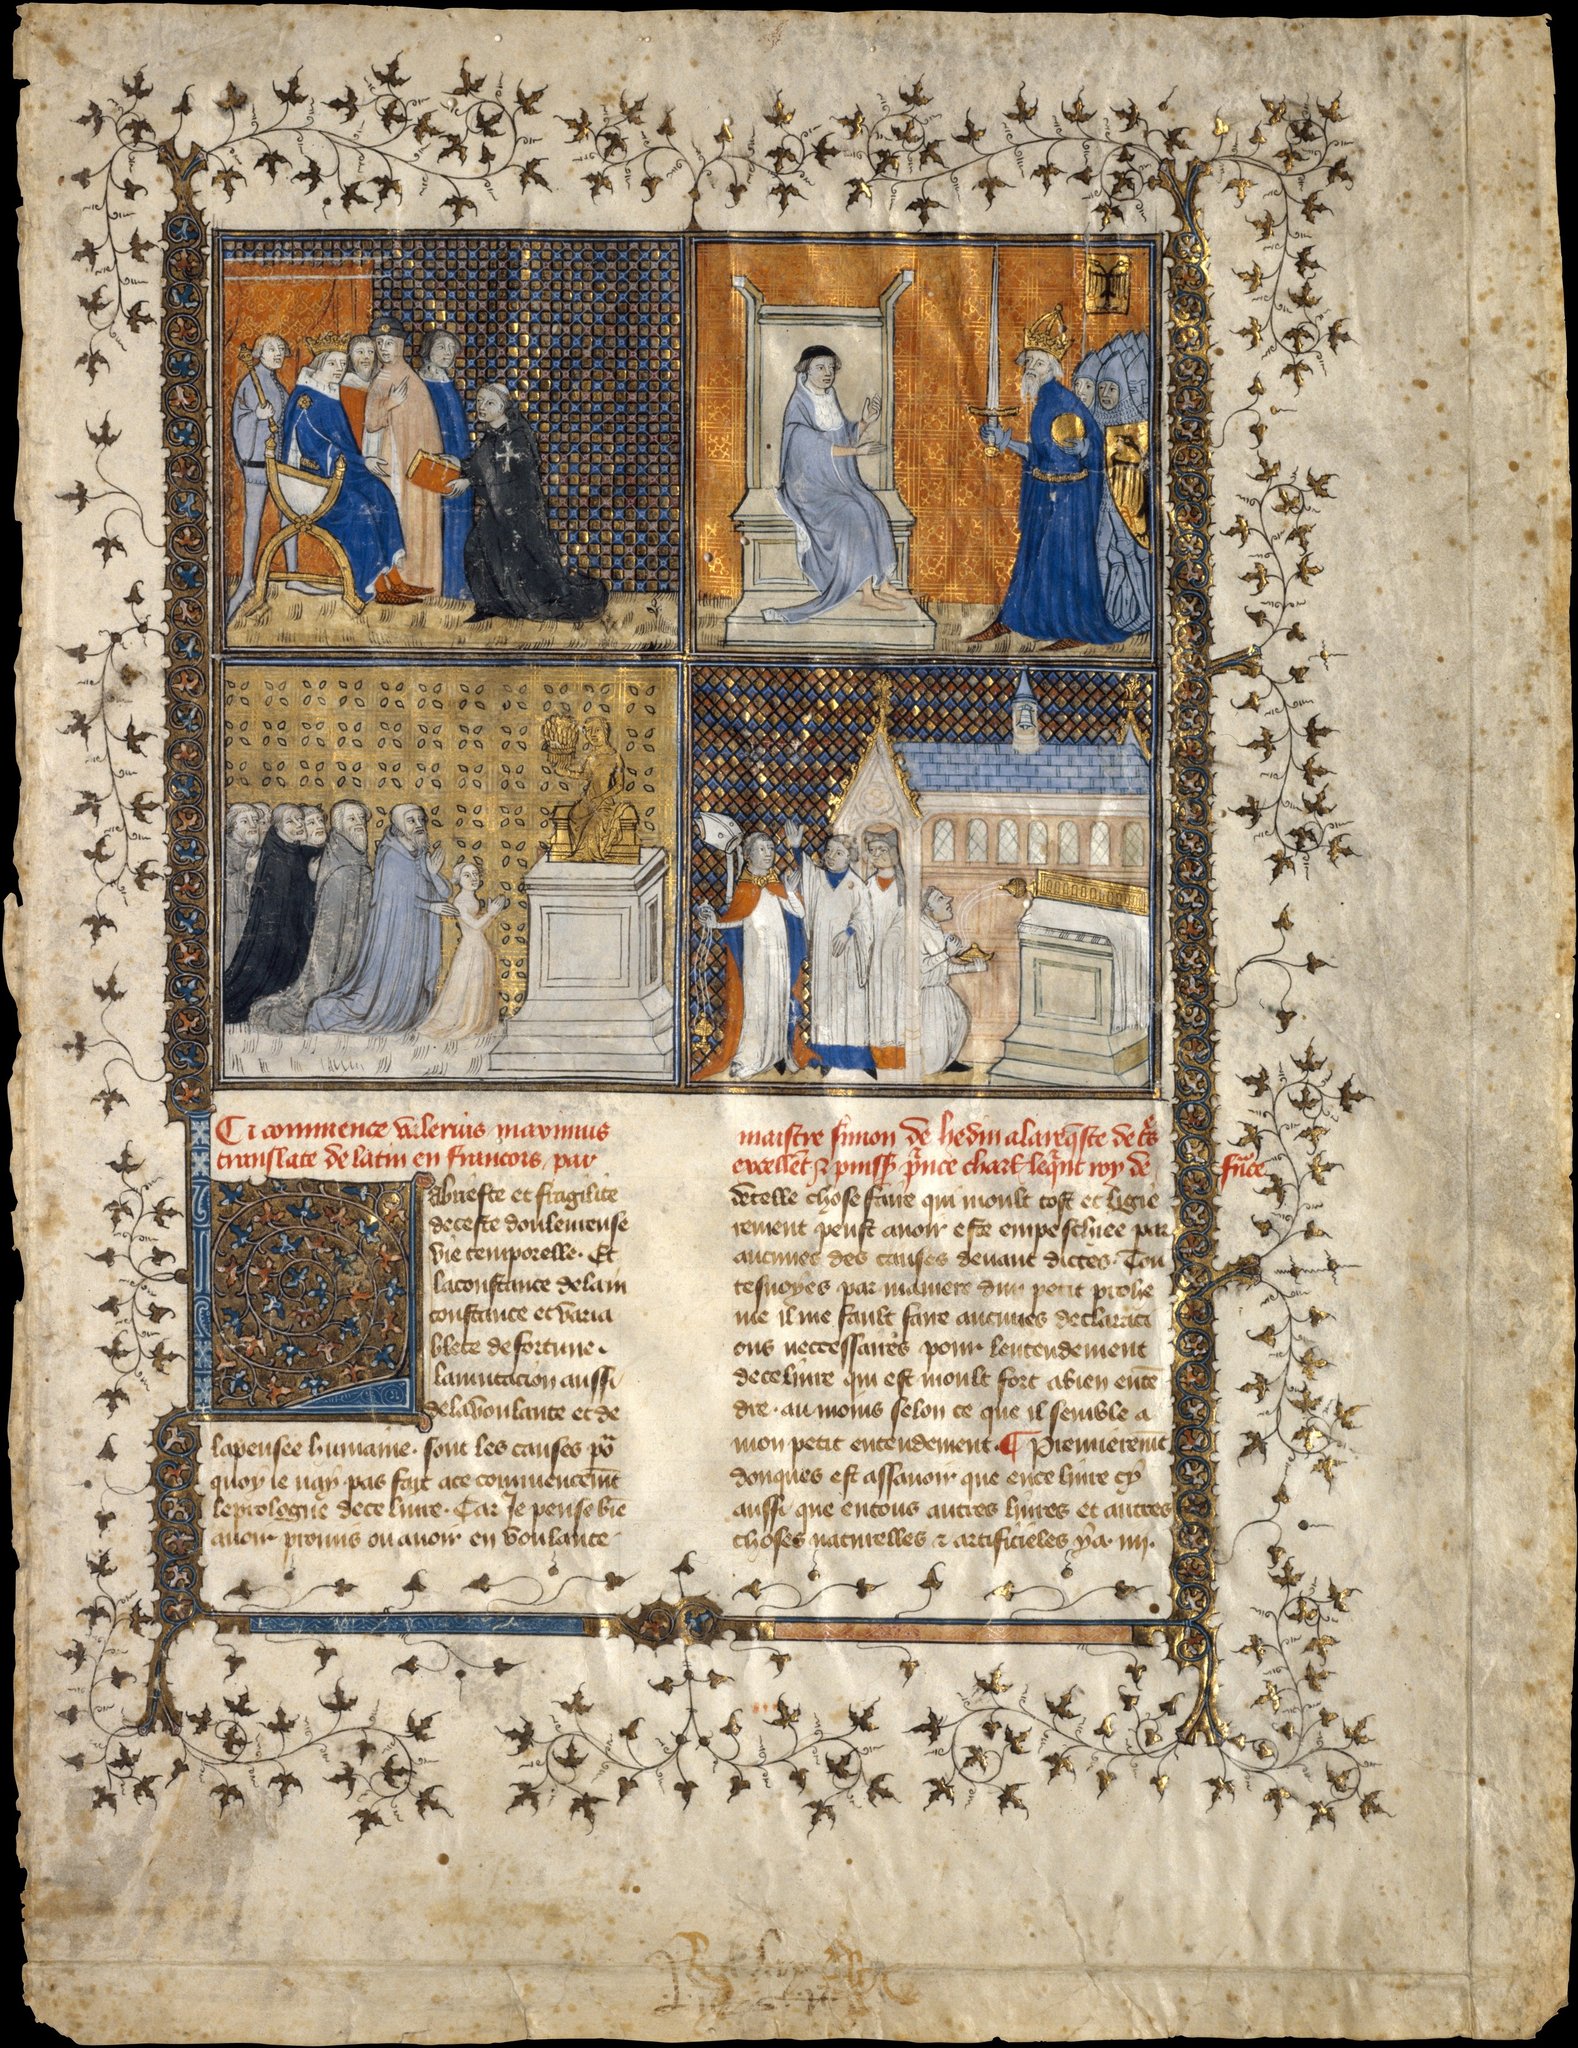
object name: manuscript leaf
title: Leaf from a Manuscript of Valerius Maximus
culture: french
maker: workshop of pierre remiet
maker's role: artist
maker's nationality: french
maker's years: 1368-1396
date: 1380-1390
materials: gold, ink, parchment, paint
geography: france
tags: altars,kings,men,ceres,bishops